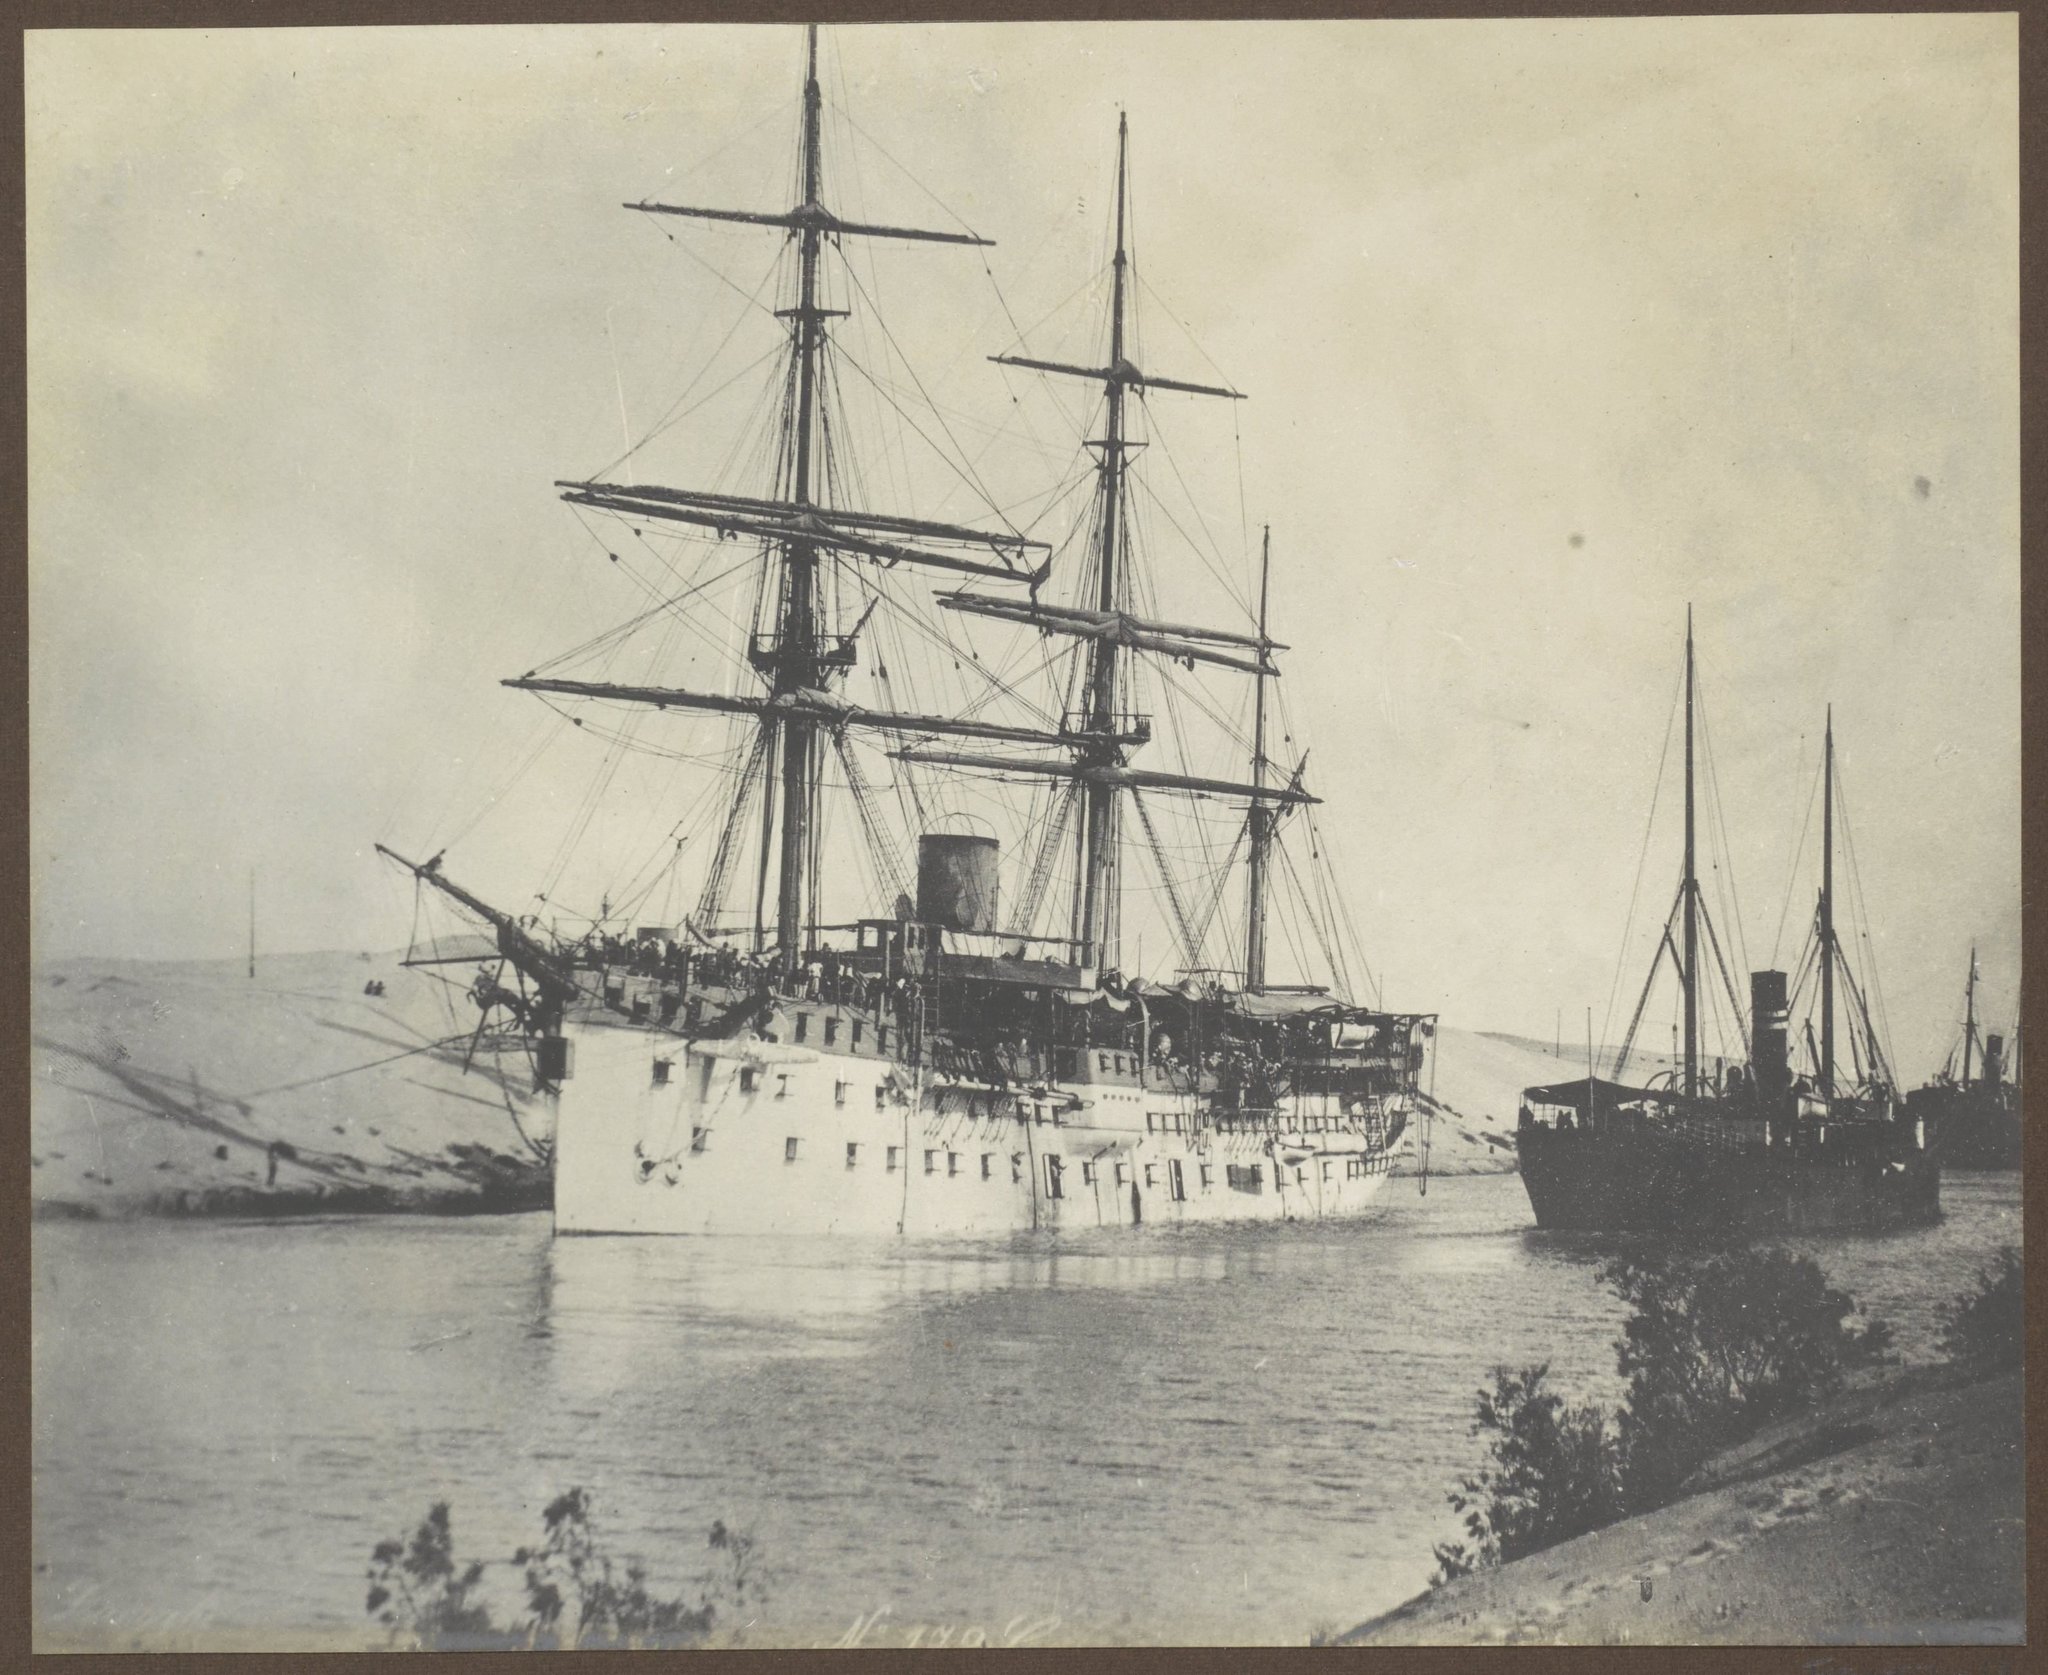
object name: photograph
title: Schepen varen door het Suezkanaal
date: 1880-1900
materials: paper, photographic support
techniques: gelatin silver print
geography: suez canal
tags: sailing-ship, sailing-boat, canal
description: Onderdeel van Reisalbum met foto's van Duitsland, Zwitserland, het Suezkanaal en Nederlands-Indië.